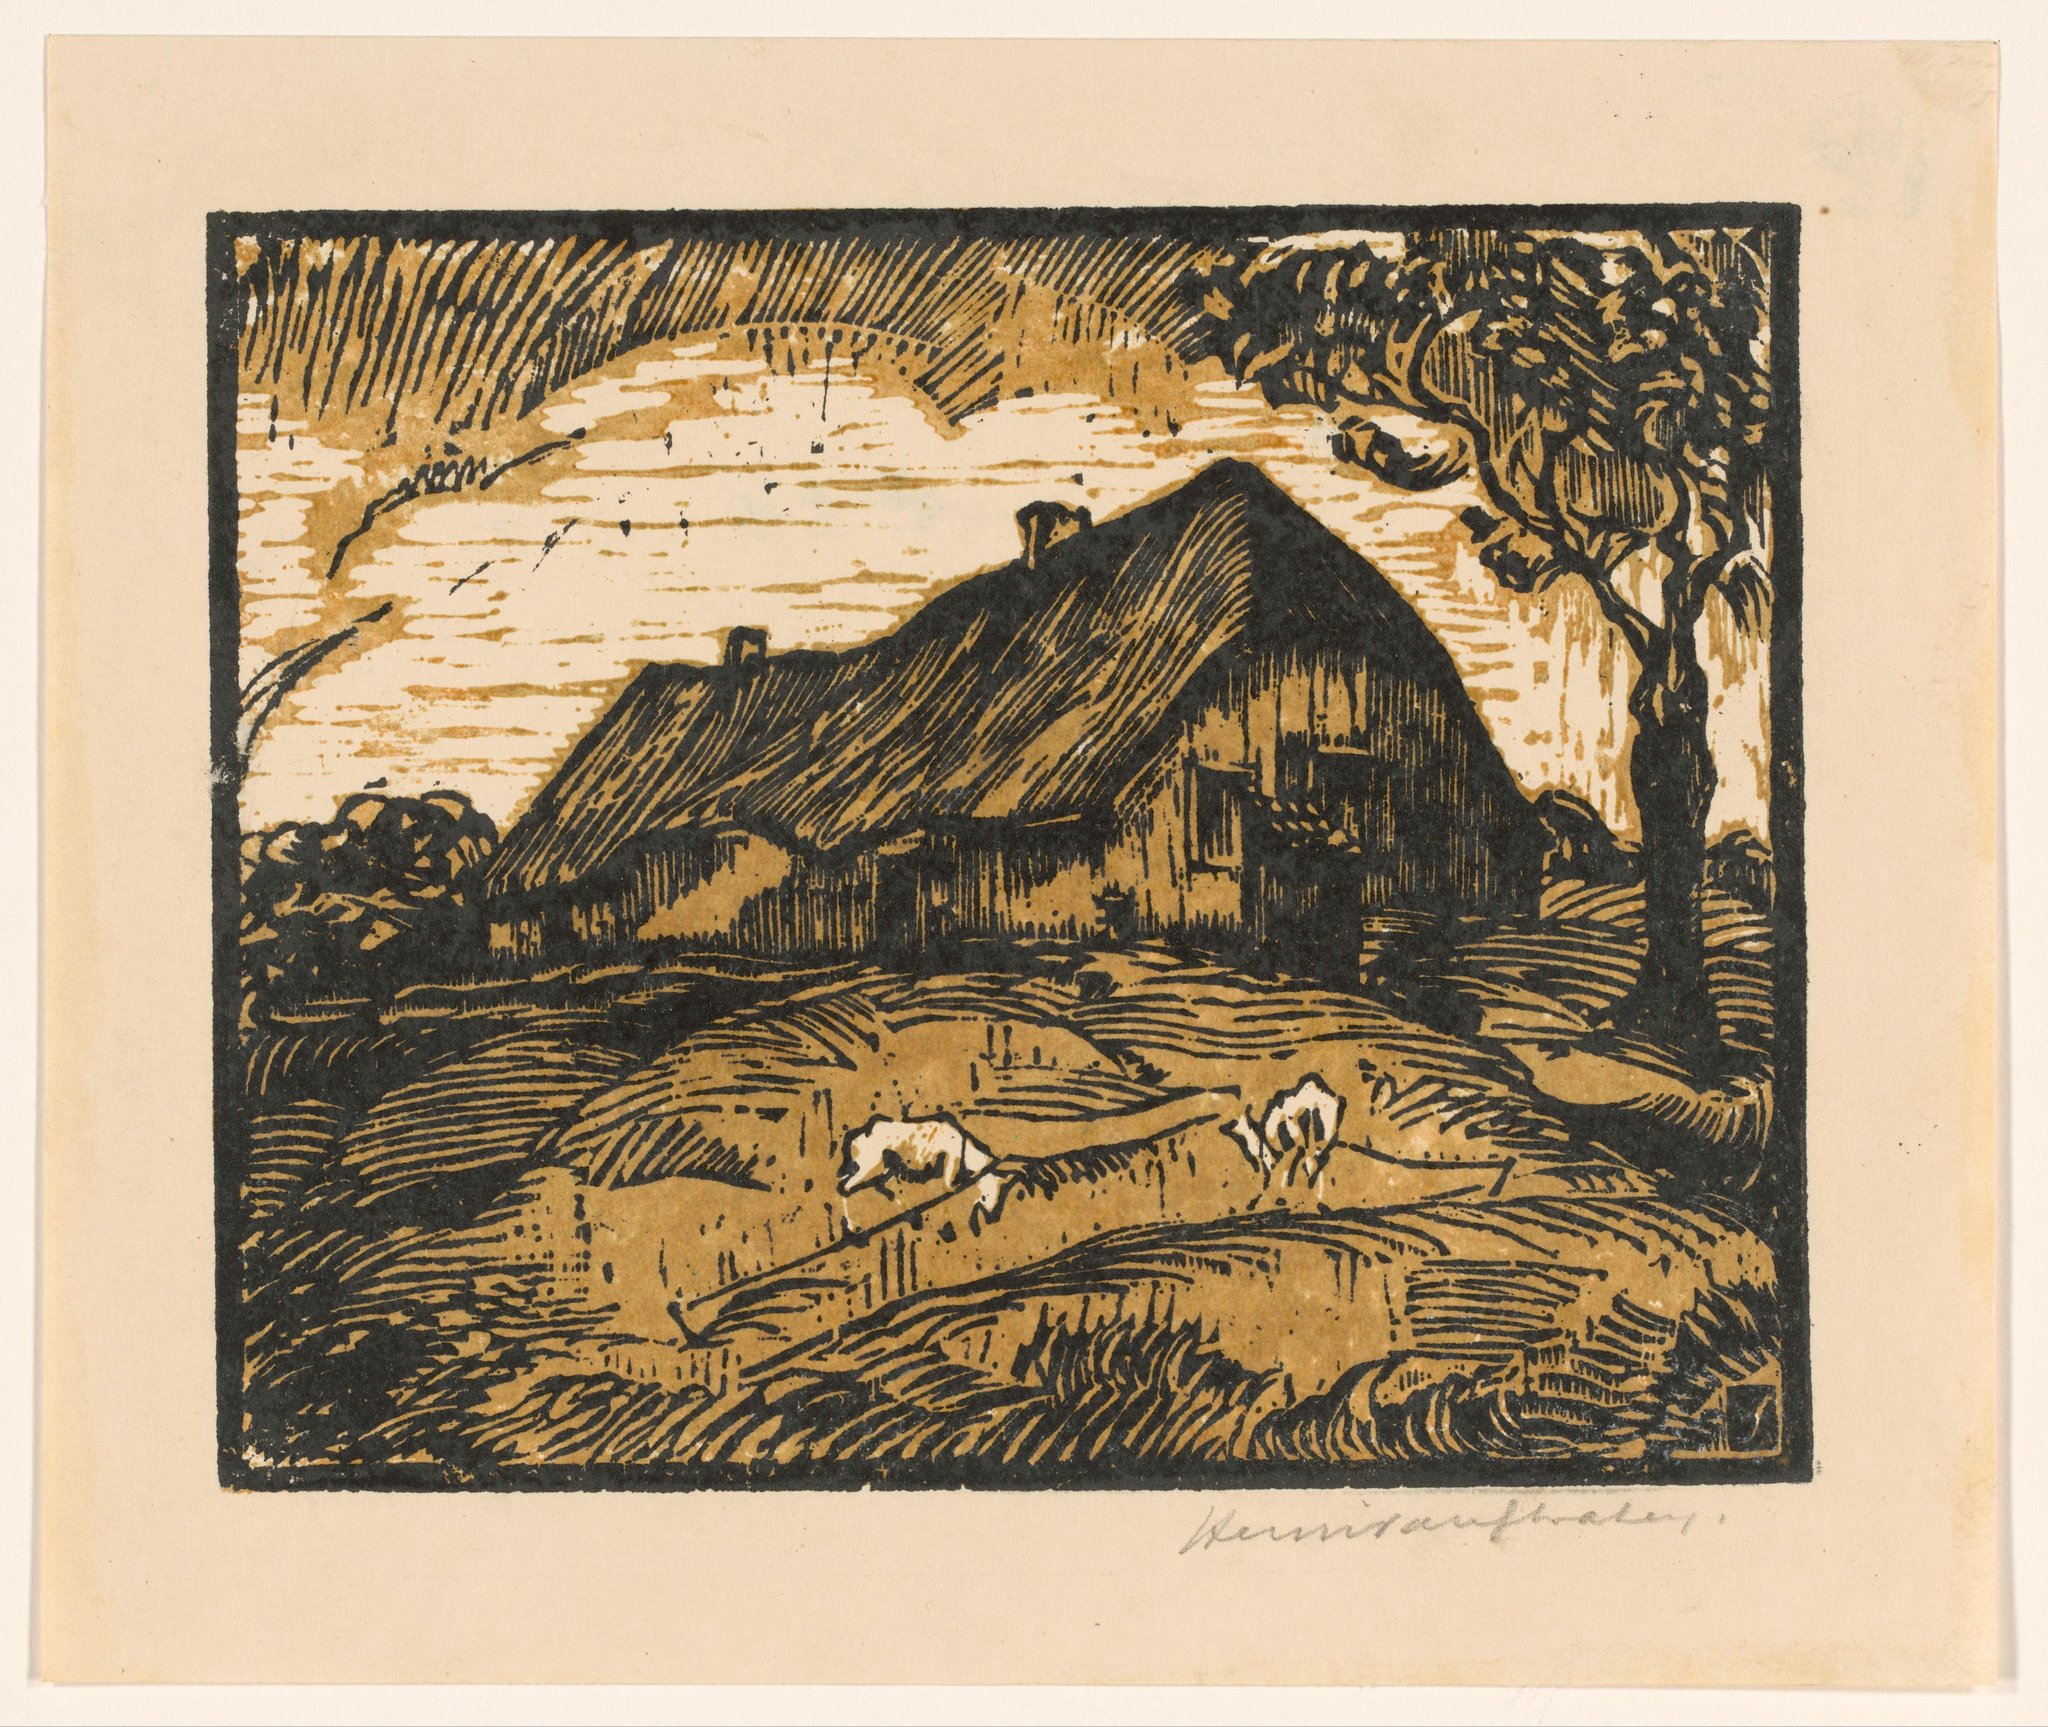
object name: print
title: Boerderij met geiten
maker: hendrik van straten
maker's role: print maker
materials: paper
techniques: linocut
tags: goat, farm or solitary house in landscape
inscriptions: collector's mark: Lugt 2228